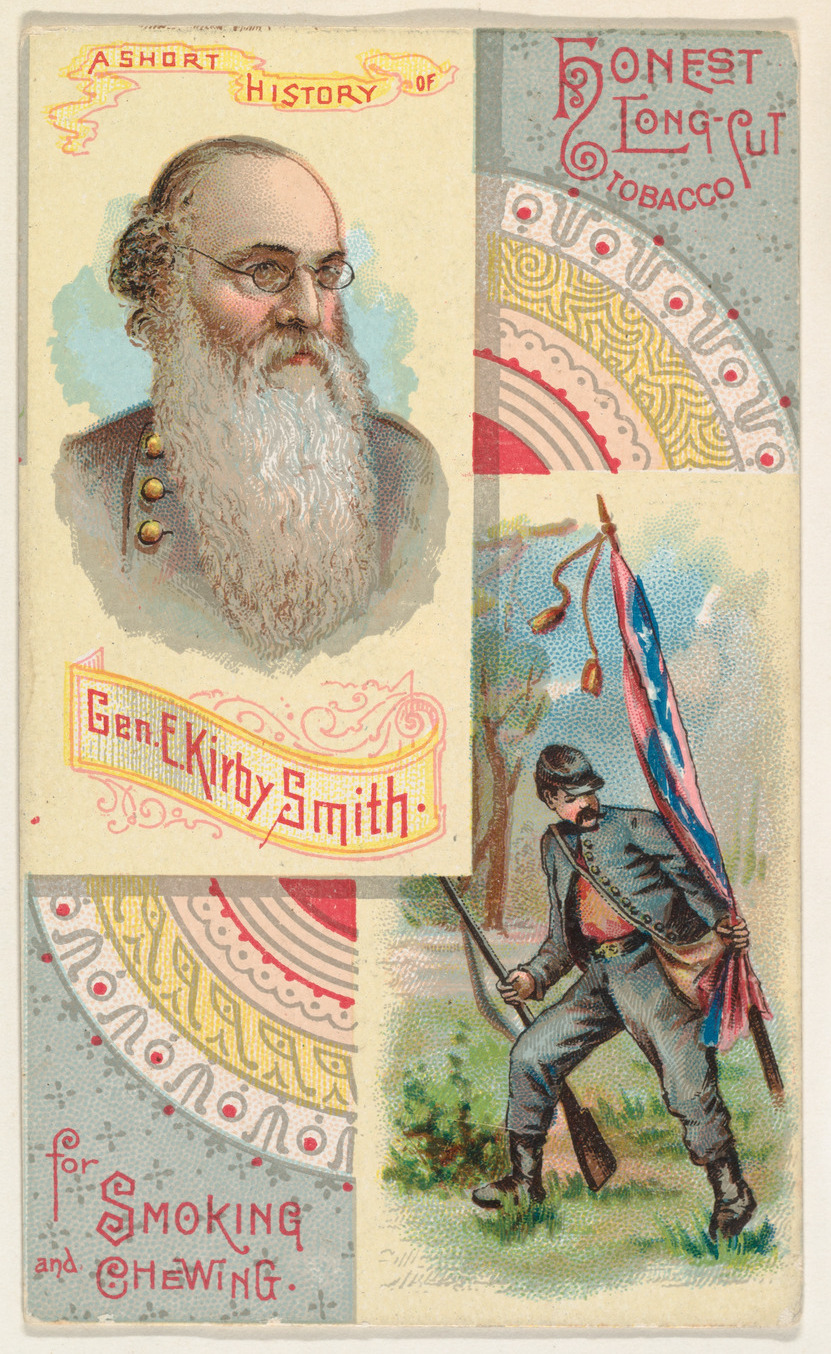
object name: print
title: A Short History of General E. Kirby Smith, from the Histories of Generals series (N114) issued by W. Duke, Sons & Co. to promote Honest Long Cut Smoking and Chewing Tobacco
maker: w. duke, sons & co.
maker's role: publisher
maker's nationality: american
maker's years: 1870-1920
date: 1888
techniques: color lithograph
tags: men,profiles,generals